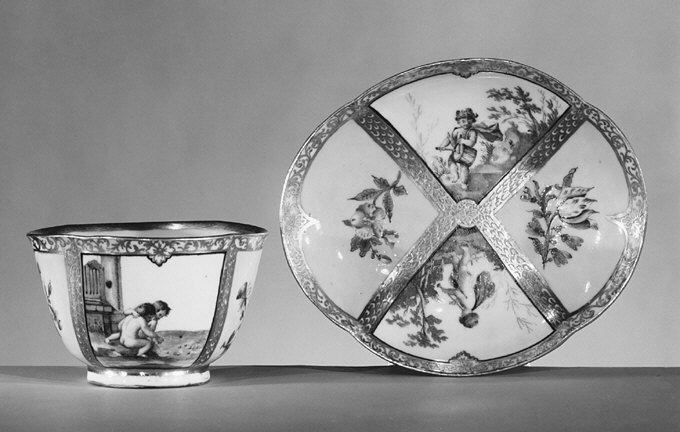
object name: cup and saucer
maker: doccia porcelain manufactory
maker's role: manufactory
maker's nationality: italian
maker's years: 1737-1896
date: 1750-1755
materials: hard paste porcelain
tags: musical instruments,putti